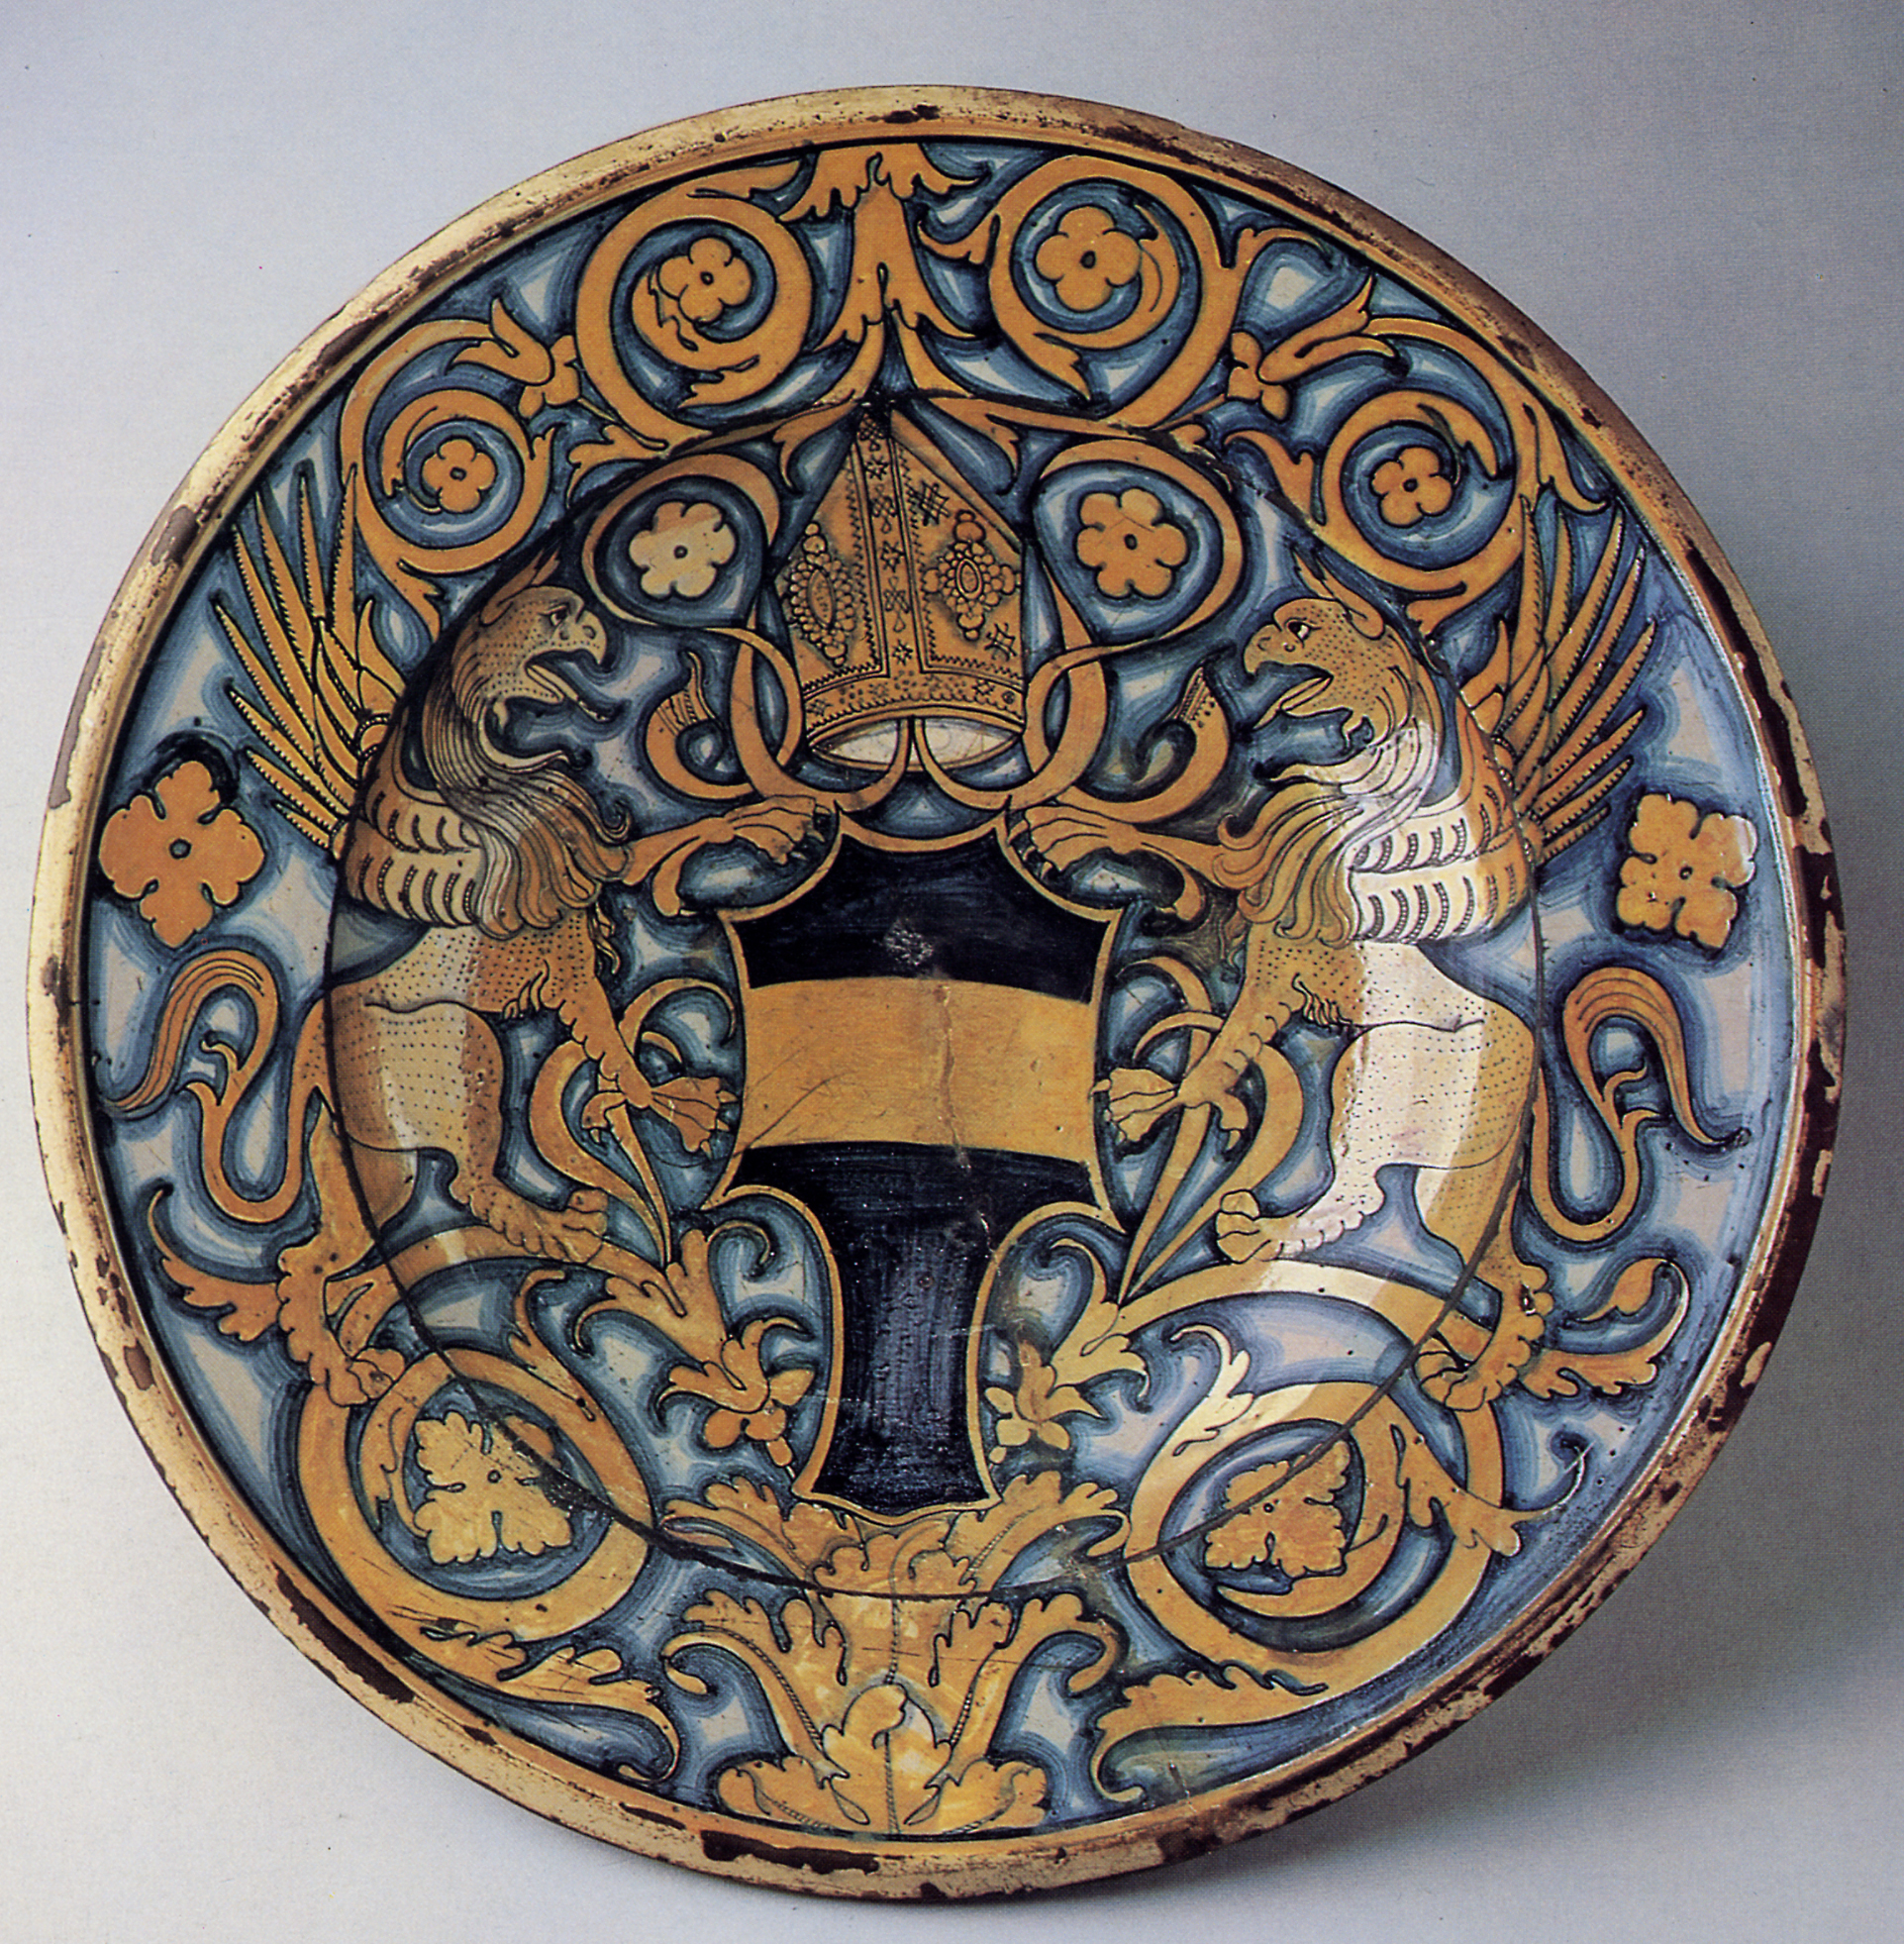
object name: dish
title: Dish (piatto)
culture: italian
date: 1515-1520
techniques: maiolica, glazing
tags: coat of arms